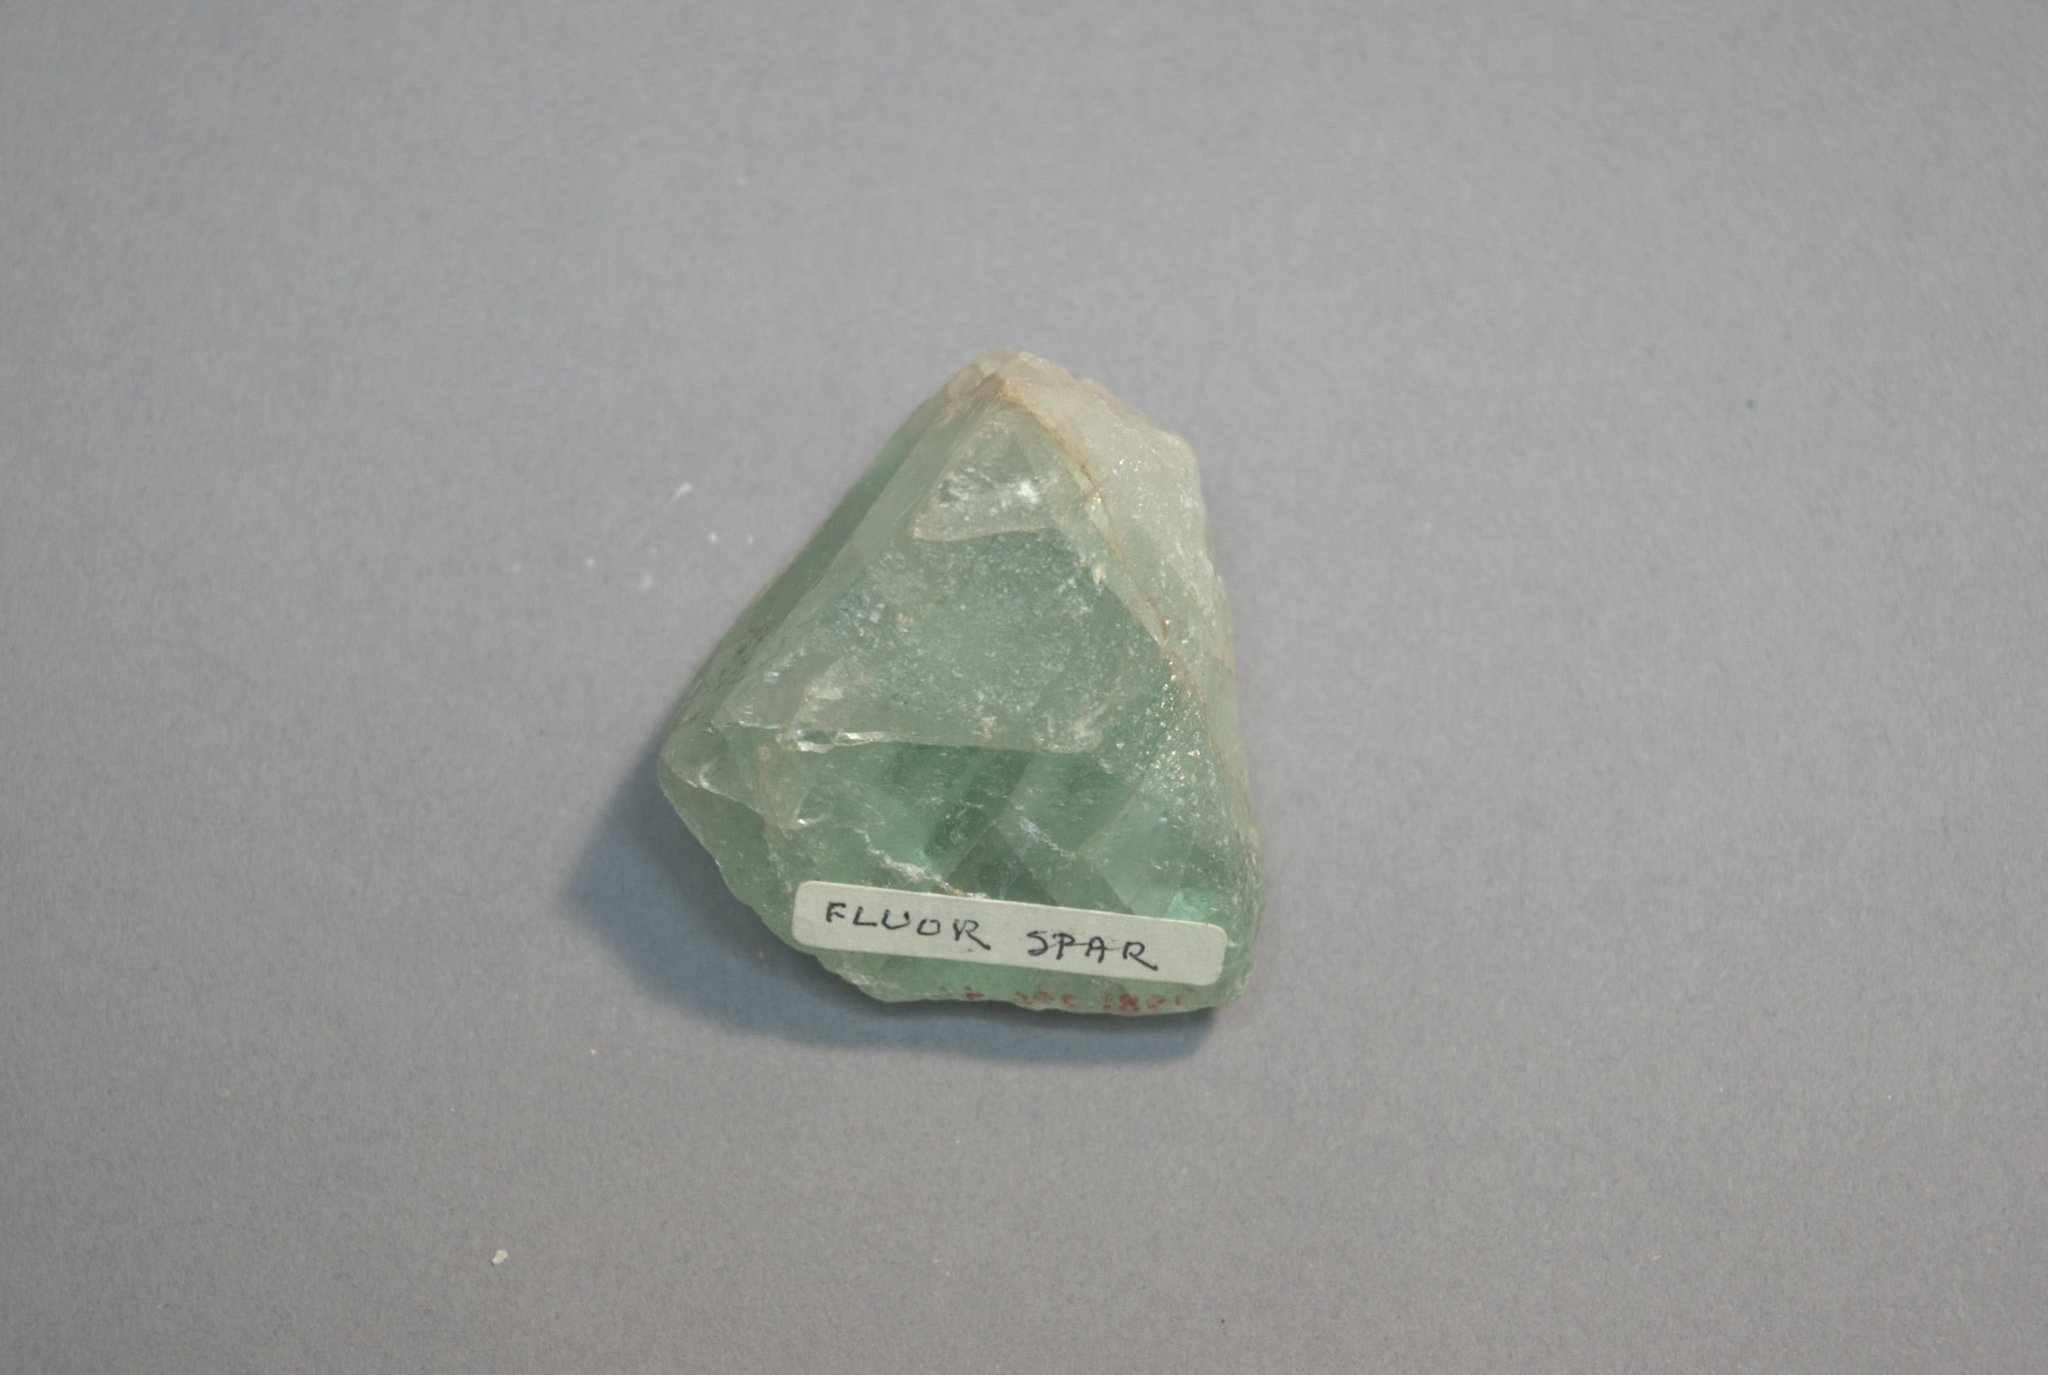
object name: jade carving material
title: Sample of Fluorspar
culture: chinese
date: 1901-2000